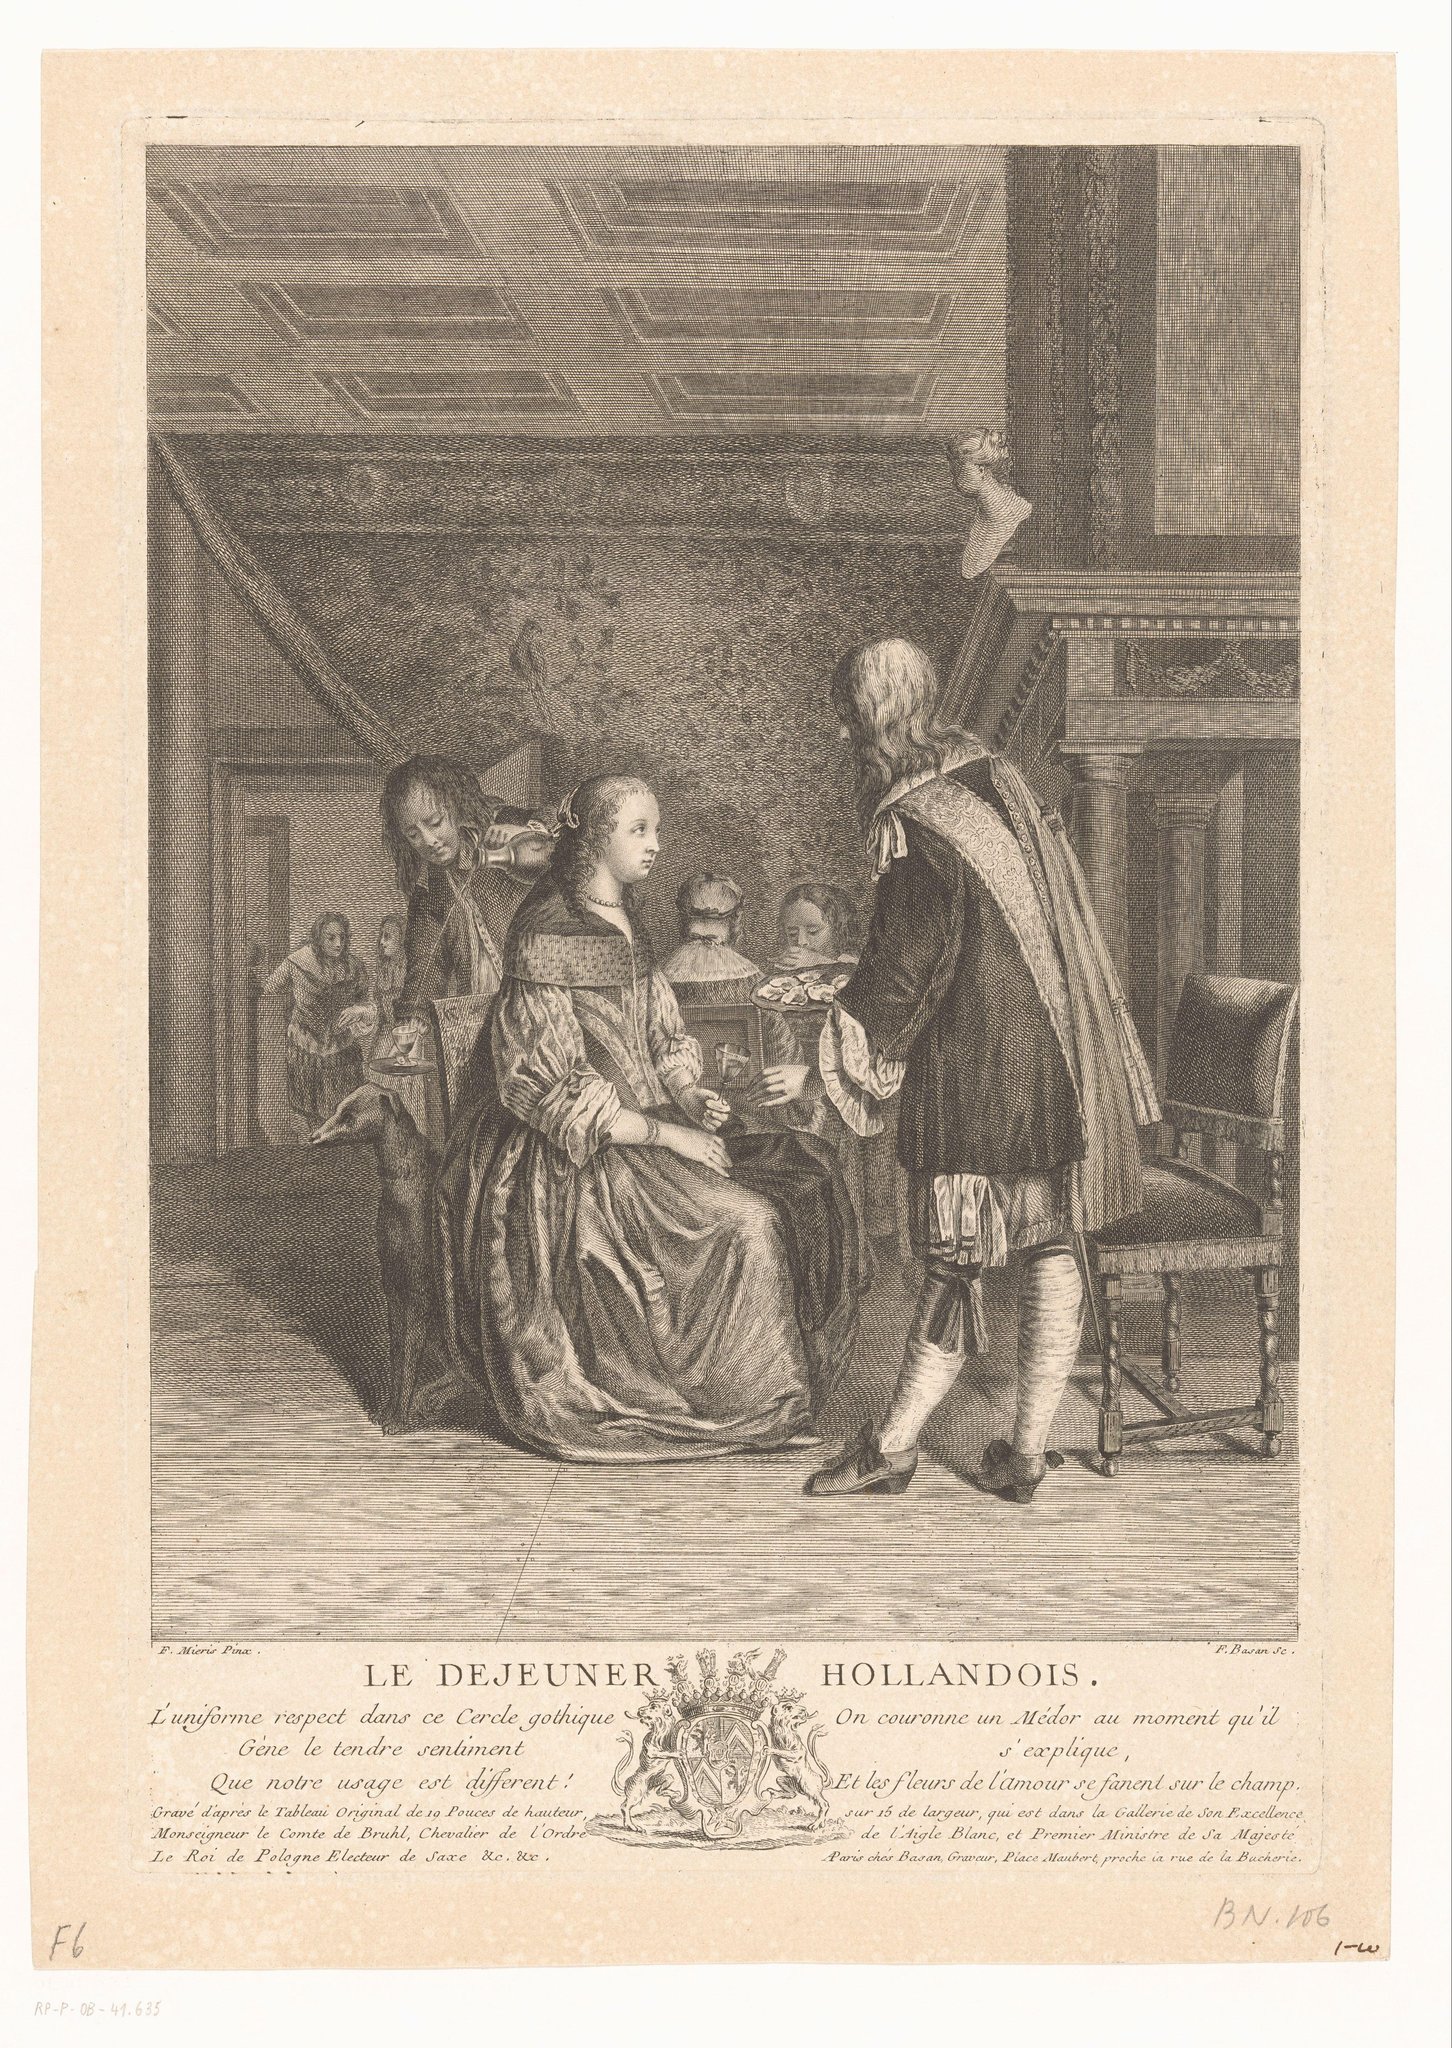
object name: print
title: Le dejeuner hollandois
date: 1733-1797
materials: paper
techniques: engraving, etching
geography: paris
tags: breakfast, servant, molluscs: oyster, dog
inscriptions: collector's mark: Lugt 2228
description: Pendant van 'Le lever hollandois' (IFF 18e siècle).